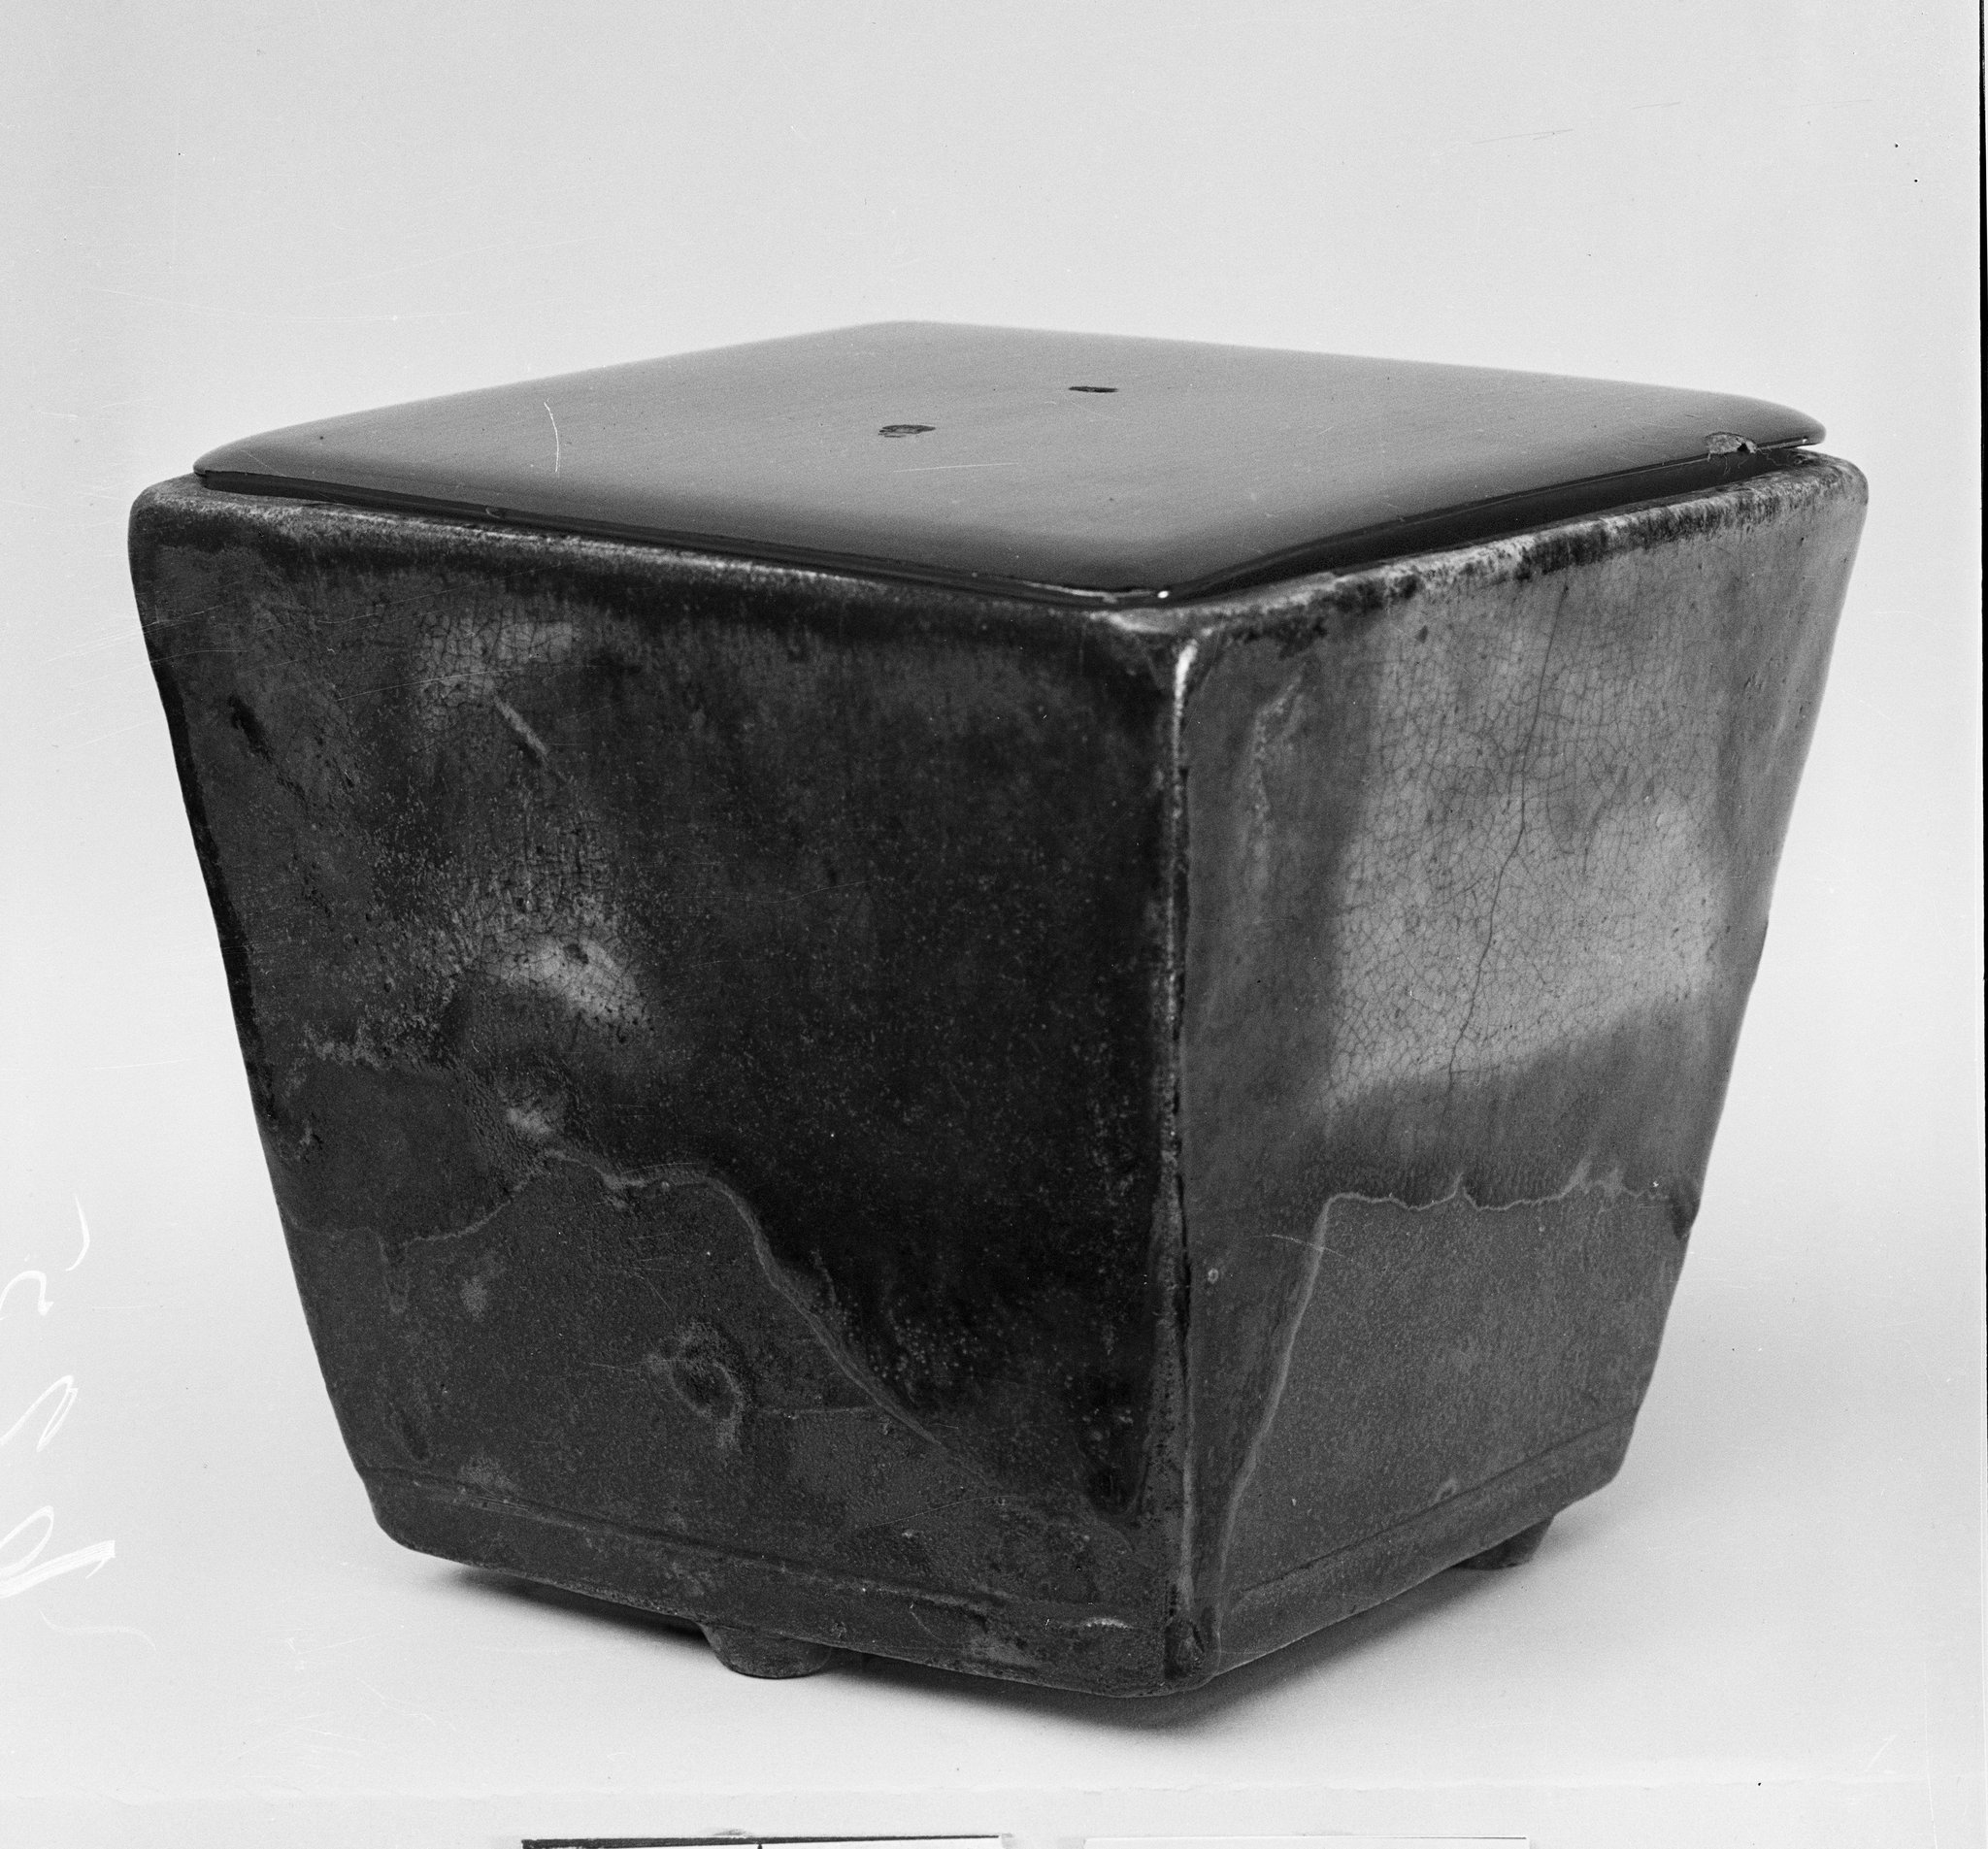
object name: bowl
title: Square Bowl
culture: japanese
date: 1700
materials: clay, glaze, lacquer